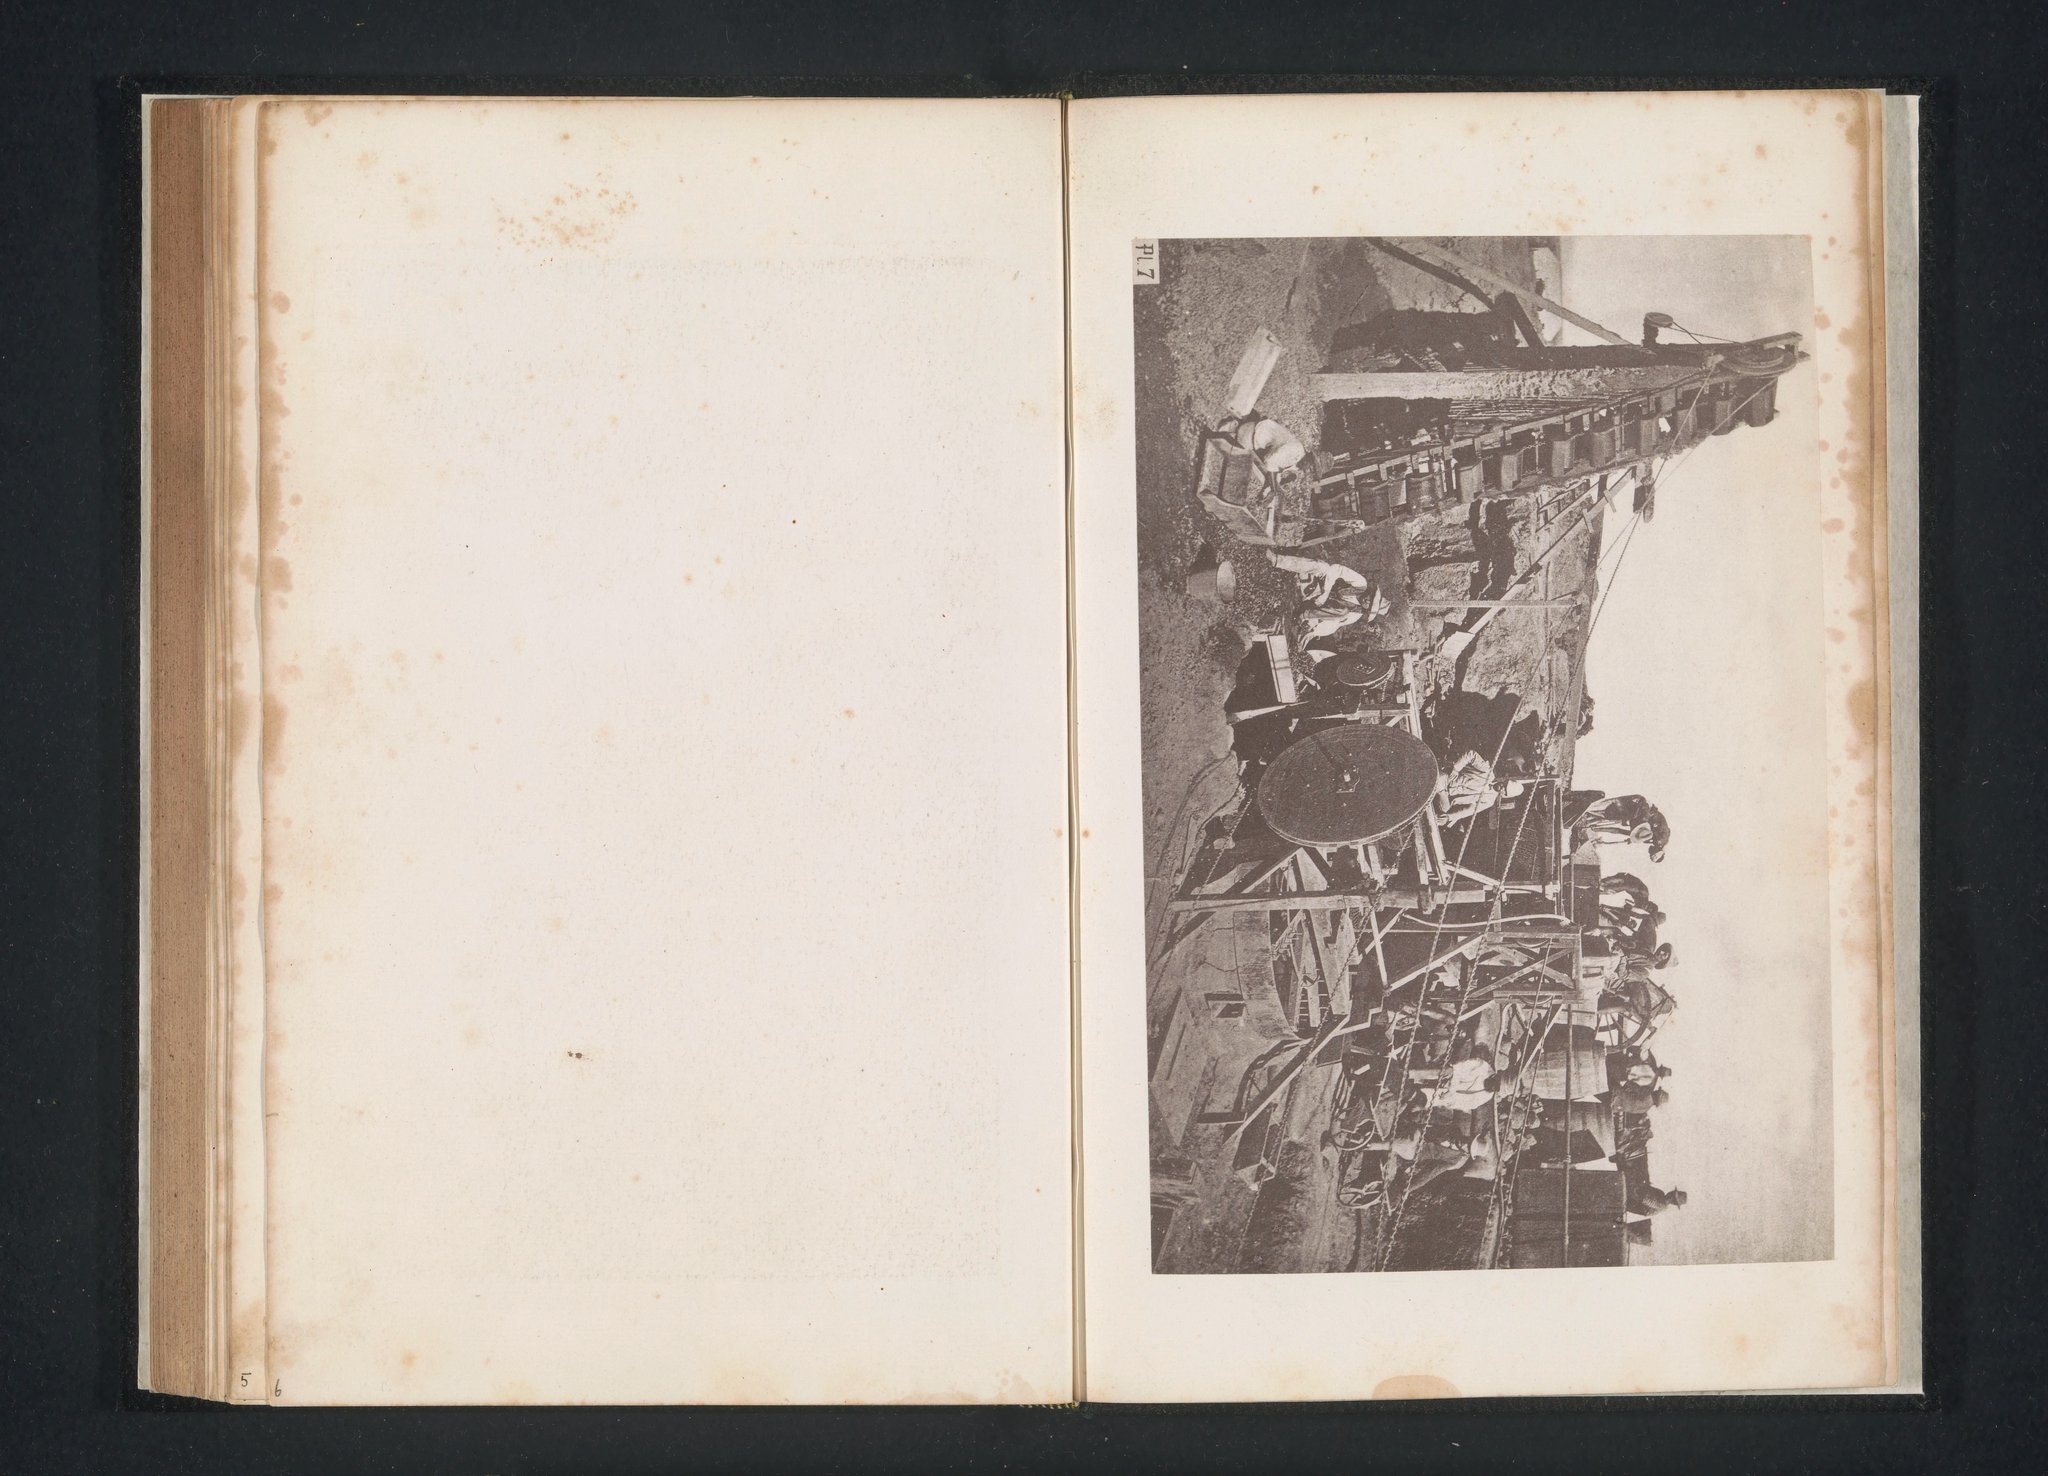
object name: photomechanical print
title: Mannen aan het werk in een diamantmijn in Zuid-Afrika, vermoedelijk bij Kimberley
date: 1870-1880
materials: paper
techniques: photograph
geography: south africa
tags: mine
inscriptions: number: ‘Pl. 7’